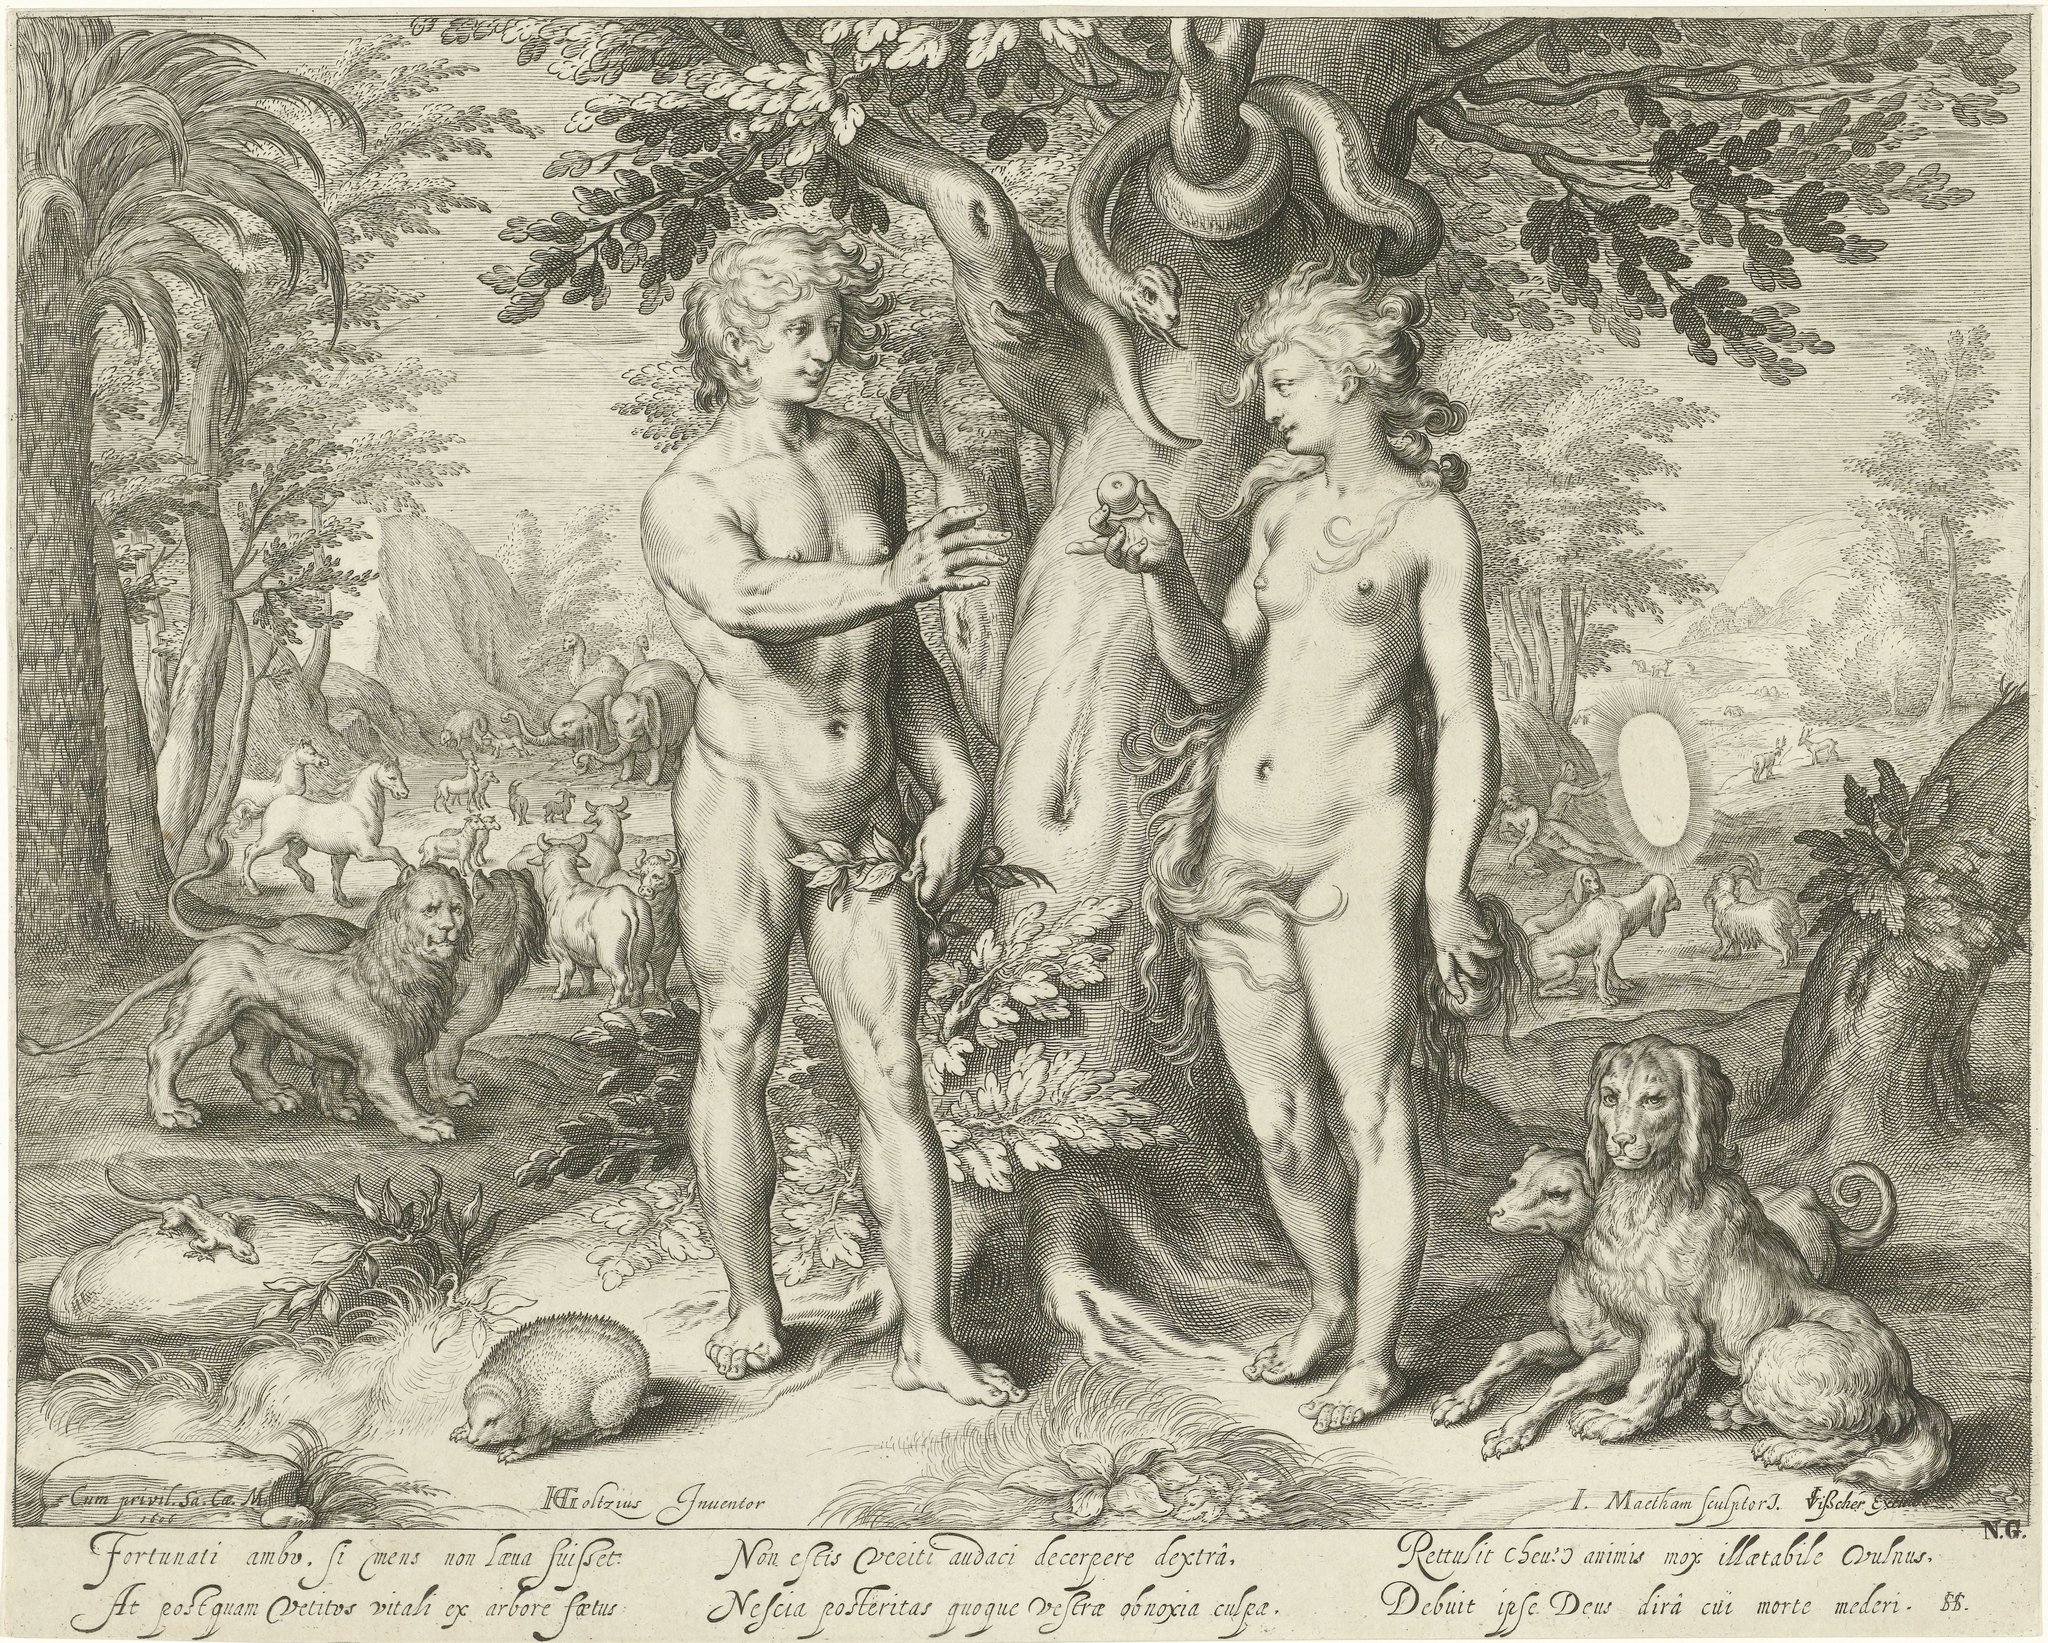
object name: print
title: Adam en Eva in het paradijs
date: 1606-1652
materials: paper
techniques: engraving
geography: amsterdam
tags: adam and eve in paradise (before the fall)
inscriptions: collector's mark: Lugt 1967, collector's mark: Lugt 2228